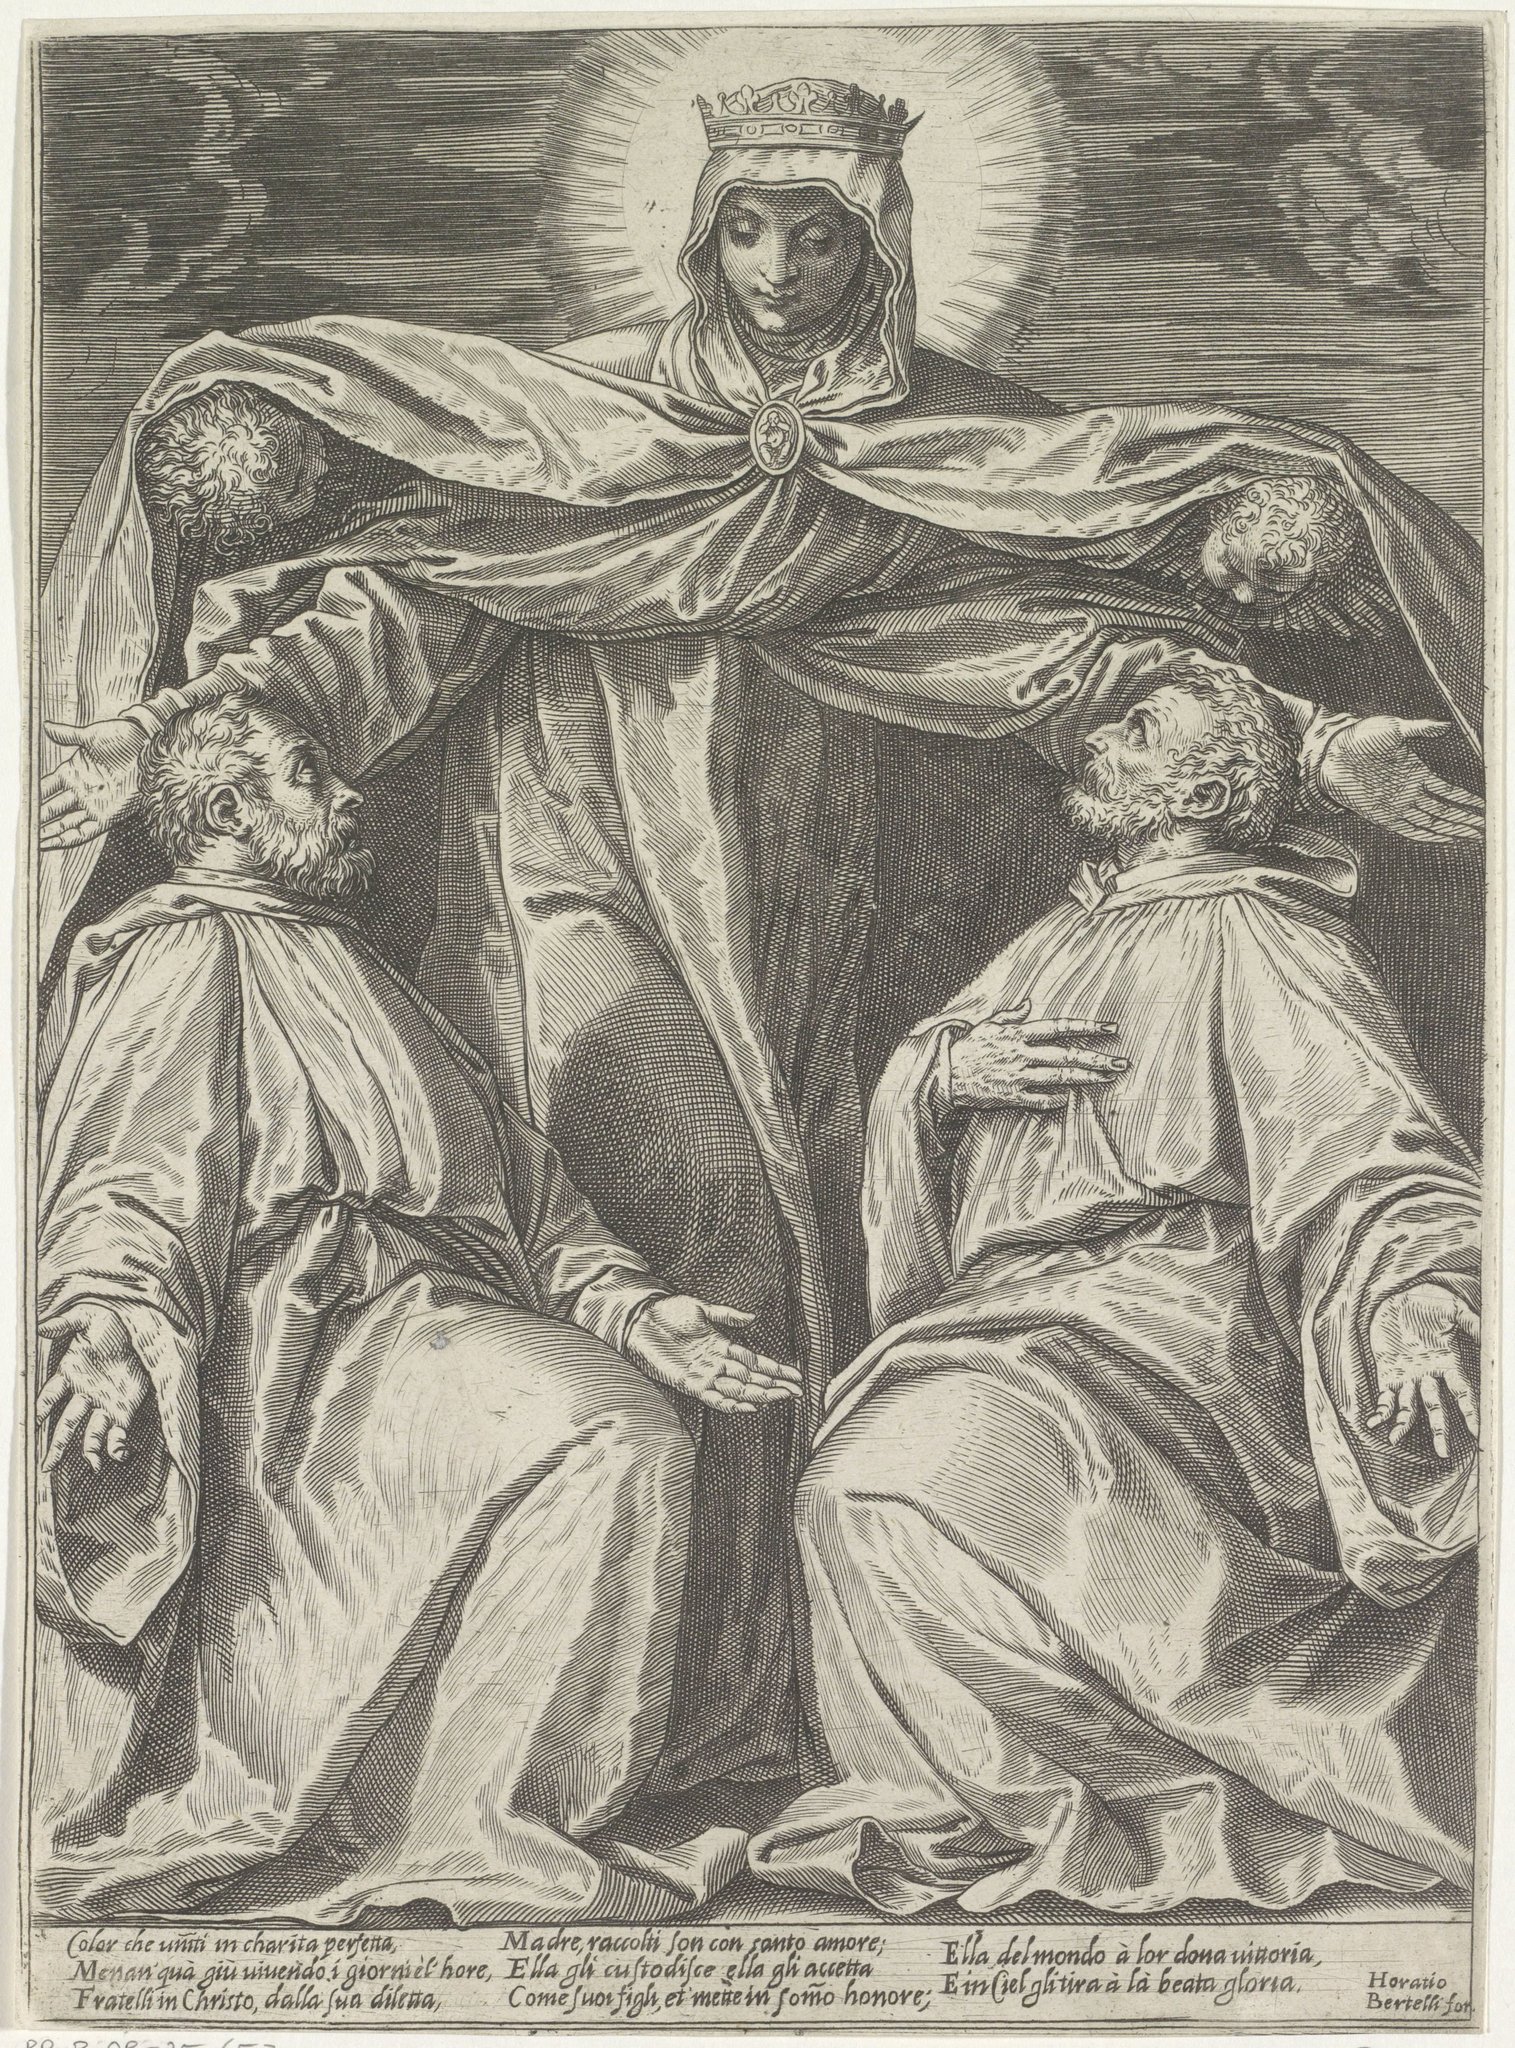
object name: print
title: Maria beschermt leden van een broederschap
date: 1582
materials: paper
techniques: engraving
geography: italy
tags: the virgin mary, mary devotion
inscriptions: collector's mark: Lugt 2228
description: Maria staat met gespreide armen. Twee cherubijnen tillen haar mantel op. Voor Maria knielen twee geestelijken. Italiaanse tekst in ondermarge.